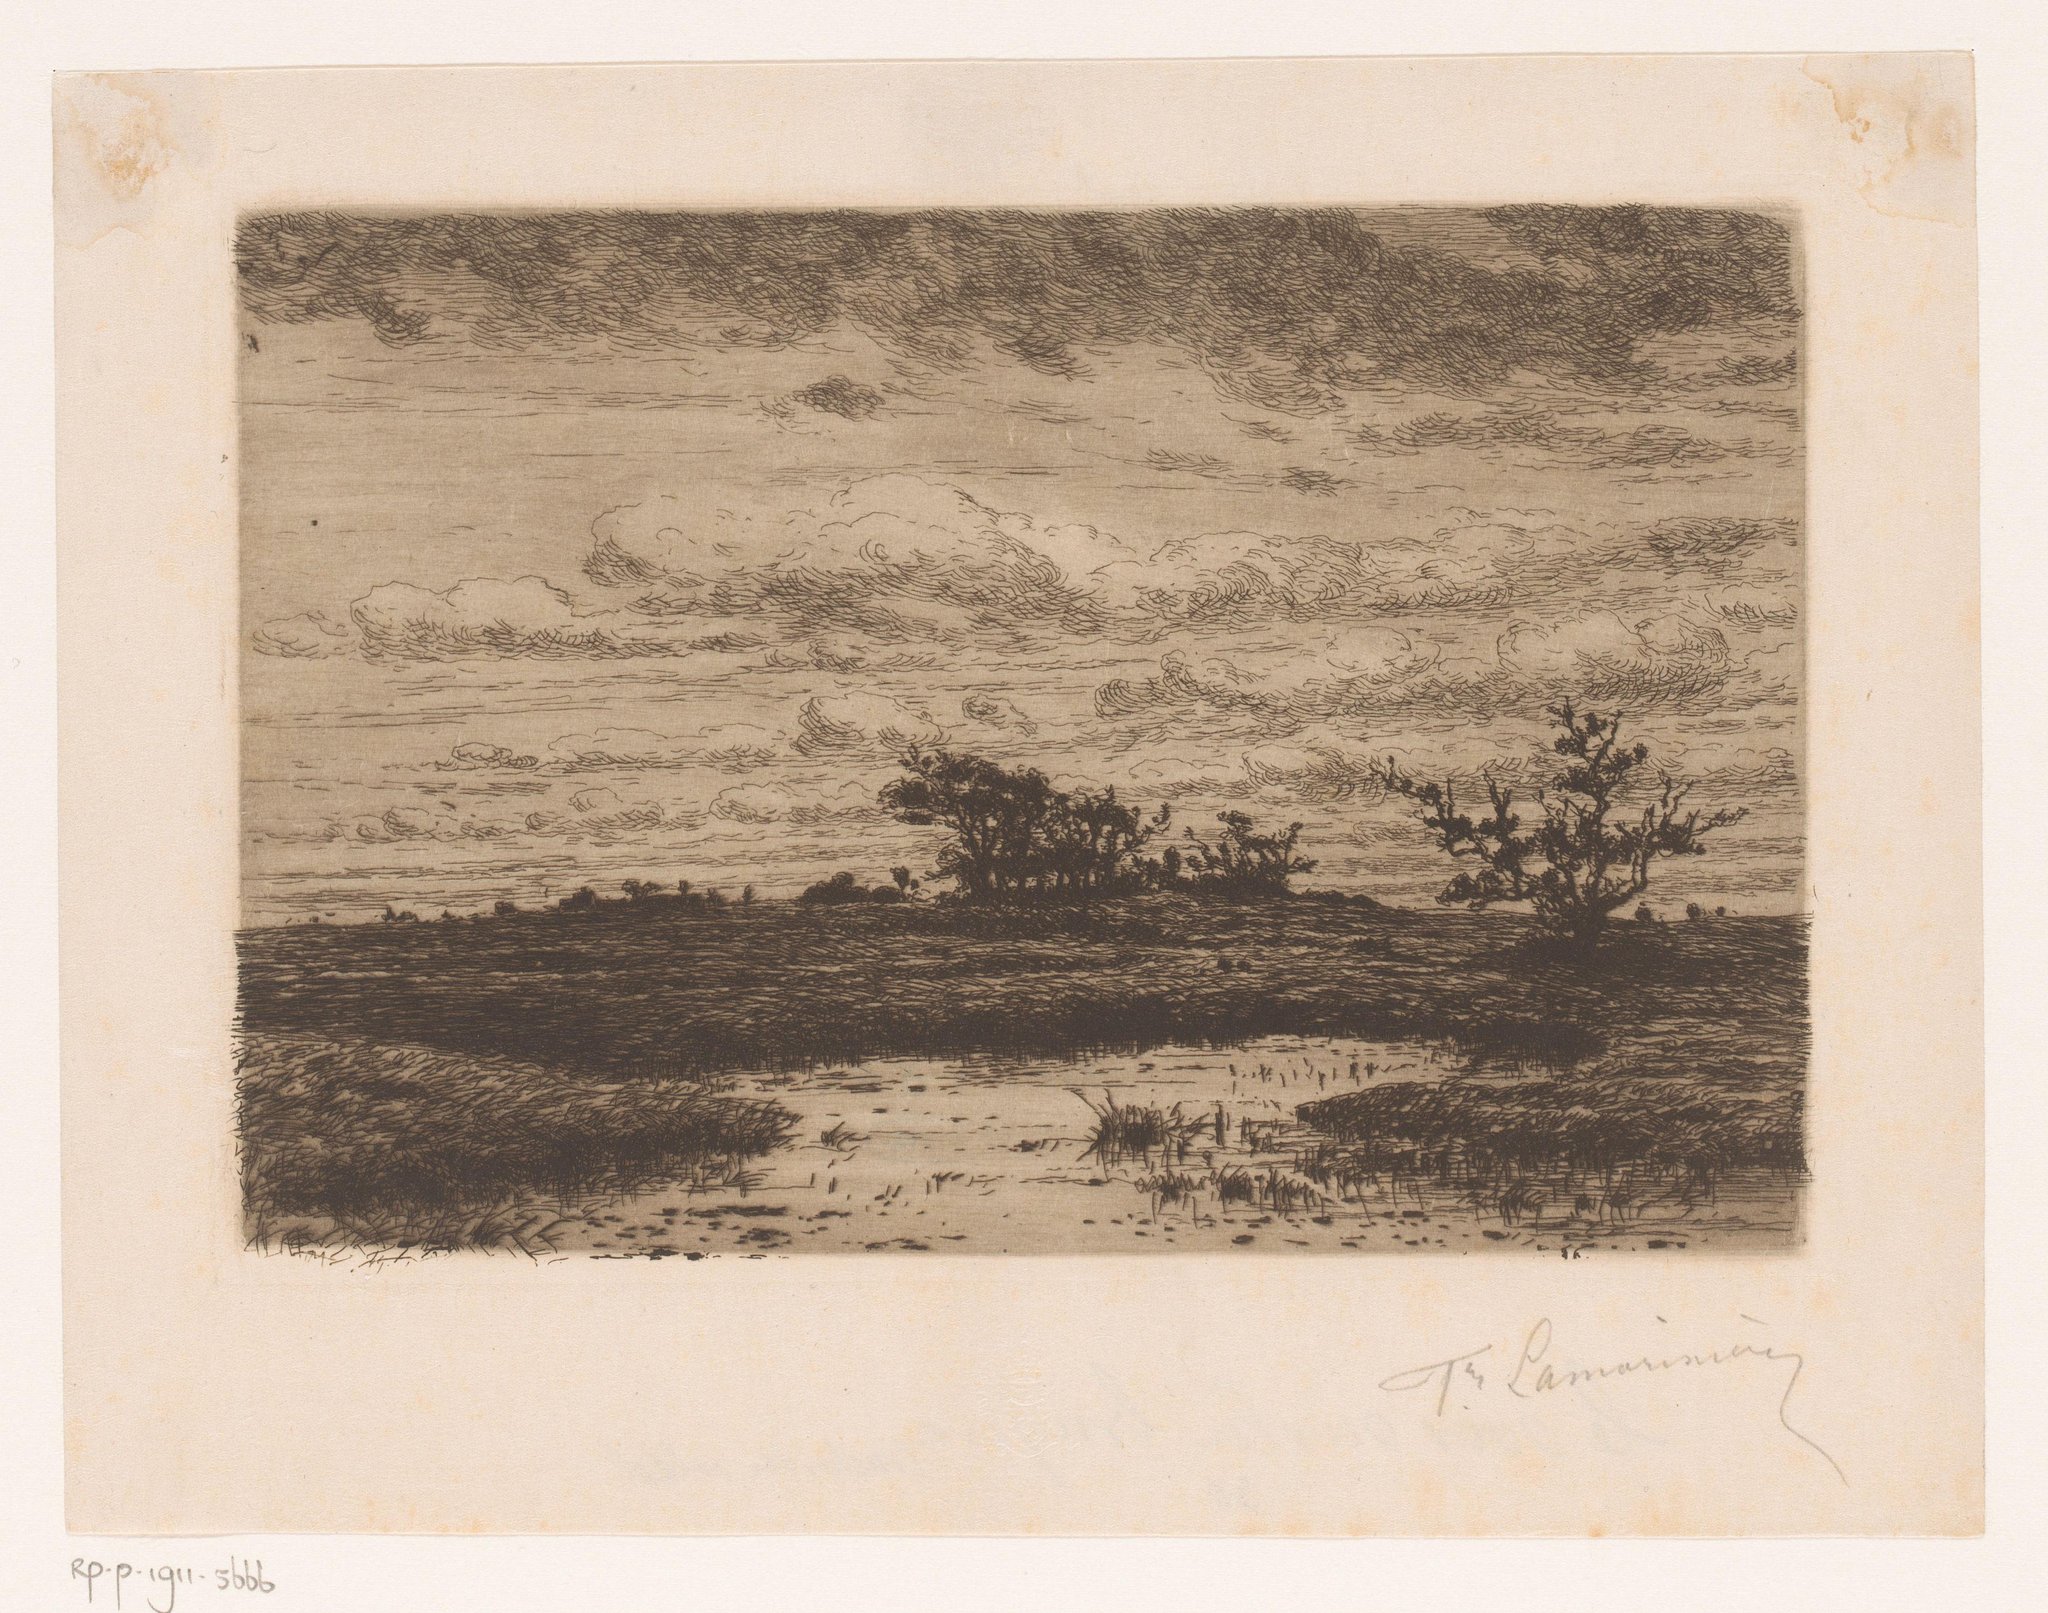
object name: print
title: Heidelandschap bij avond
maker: jean pierre françois lamorinière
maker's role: print maker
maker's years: 1828-1911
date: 1838-1911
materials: paper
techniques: drypoint, etching, intaglio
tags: fen, du. 'ven'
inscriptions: workshop stamp: ‘Antwerpsche Etsers 1880’, annotation: ‘le soir sur la bruyere’, collector's mark: Lugt 2228